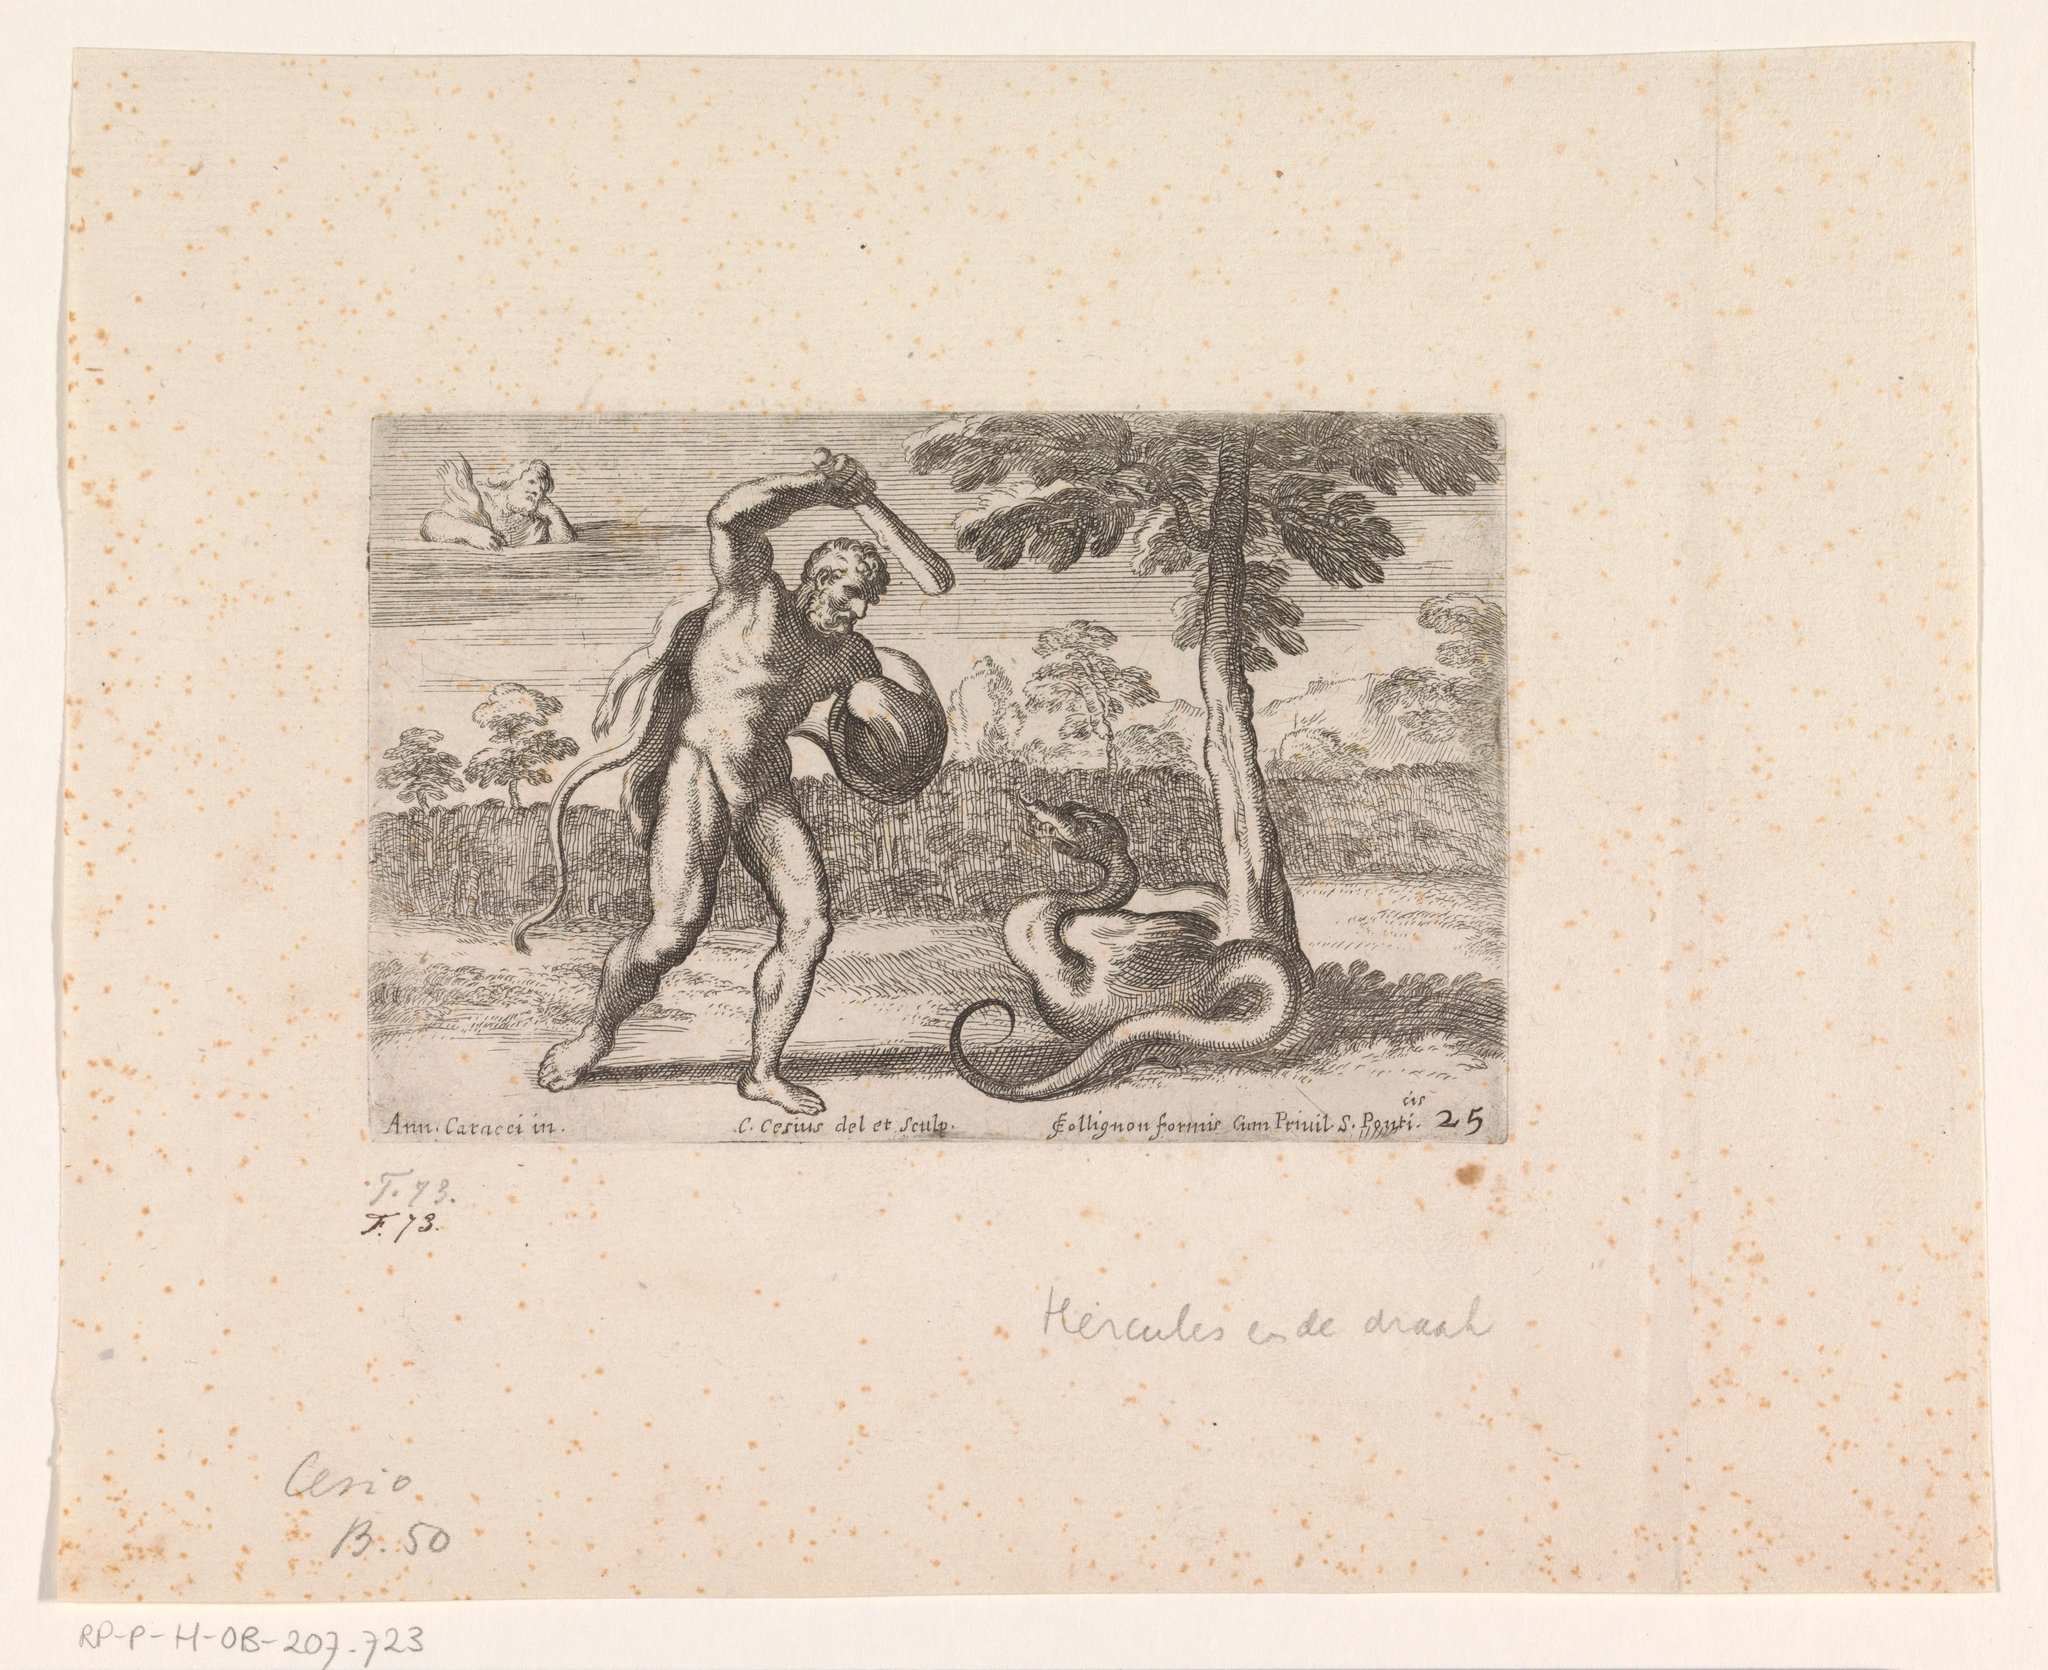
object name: print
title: Galeria nel Palazzo Farnese in Roma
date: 1656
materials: paper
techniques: etching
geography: italy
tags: hercules kills ladon, the dragon which kept the tree of the hesperides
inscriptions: collector's mark: ‘Hinloopen’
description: Prent uit een reeks prenten met nummers van 1 tot en met 29 (sommige prenten hebben hetzelfde nummer), plus titelprent en opdracht, naar schilderingen in Palazzo Farnese te Rome. Deze prent maakte oorspronkelijk deel uit van liber nr. 22 van de Atlas van Rome, uit de collectie Hinloopen. In dit album waren een aantal prentreeksen naar bekende zeventiende eeuwse frescoseries bijeengebonden. In 1709 heeft Schijnvoet op last van de burgemeesters van Amsterdam de collectie herordend. De prenten uit liber 22 kwamen terrecht in Schijnvoet boek nr. 10. De laatst gedateerde reeks in het album is gedateerd 1691. Het album moet dus na deze datum gebonden zijn. De band is in de Rijksakademietijd uit elkaar gehaald. De marges van de prenten zijn bij het opbergen in het Rijksprentenkabinet vaak drastisch afgesneden. Van een aantal series waren de prenten teruggeslagen om in het album te passen. (Zie: Waals, Jan van der. De prentschat van Michiel Hinloopen. 's-Gravenhage: SDU uitgeverij, 1988, pp. 173-174.)